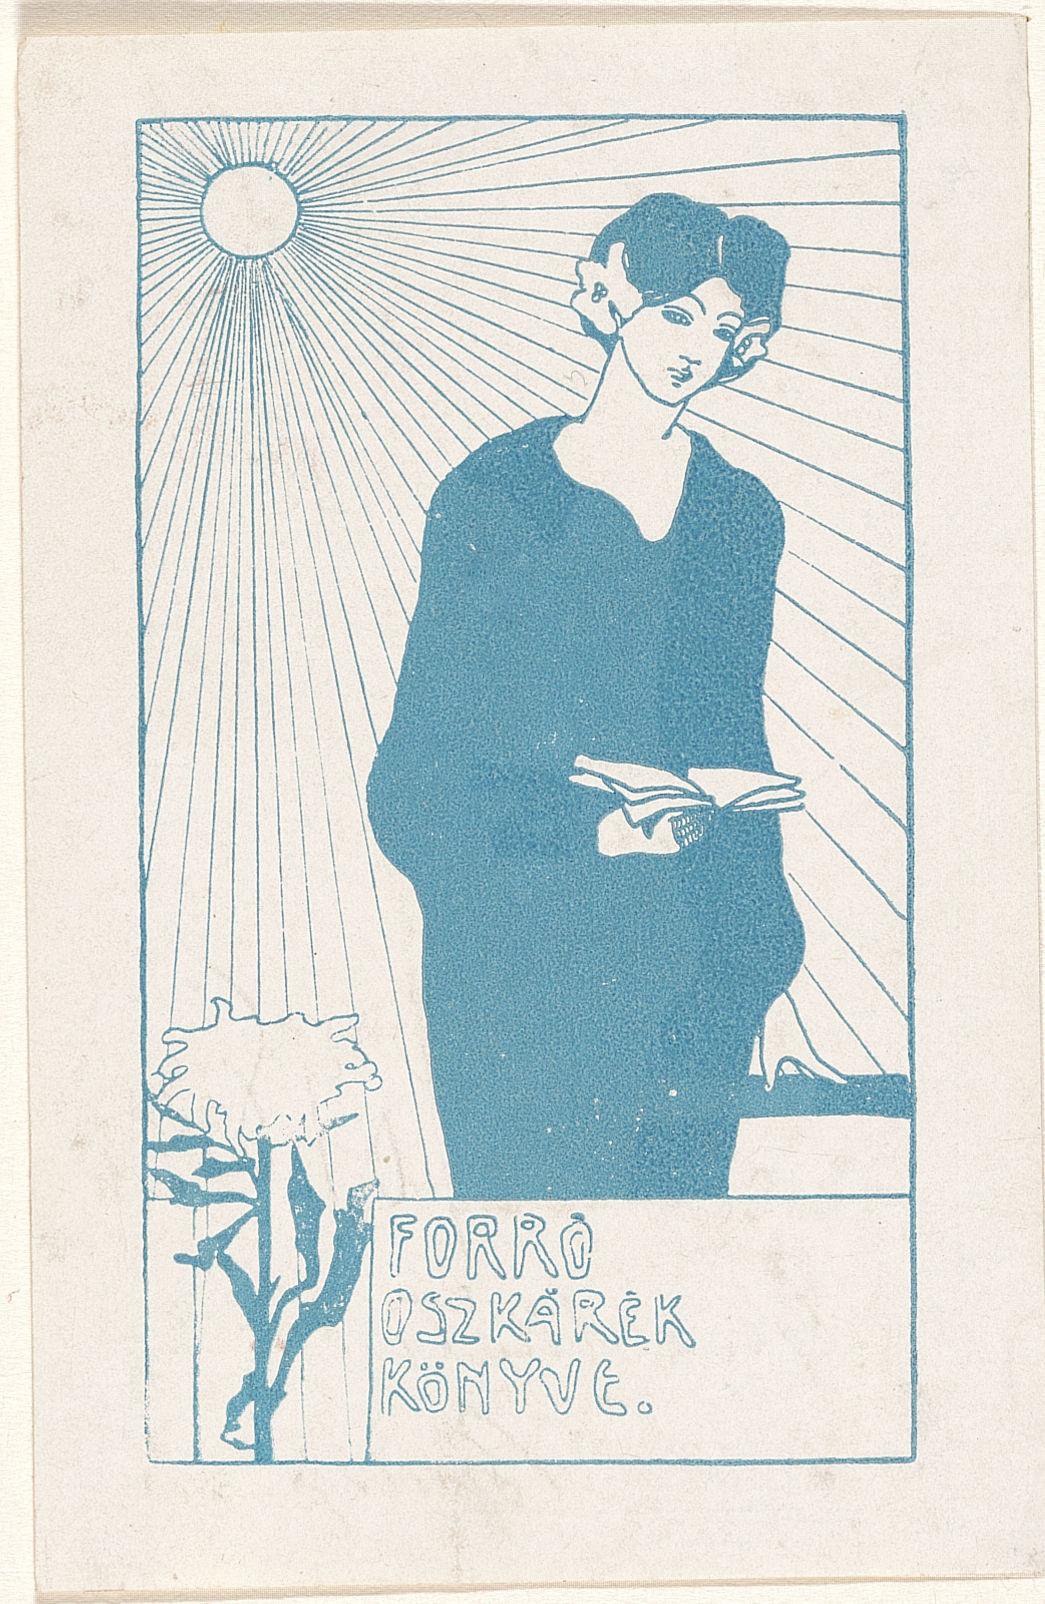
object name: bookplate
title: Ex libris van Forro Oszkarek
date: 1900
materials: paper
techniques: lithograph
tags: flowers, book, sun as celestial body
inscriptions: collector's mark: Lugt 2228, annotation: ‘9878 / Ilona Máté Budap[est]’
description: Een vrouw met een bloem in haar haar en een opengeslagen boek in haar handen. In de achtergrond een stralende zon. In de voorgrond een bloem.